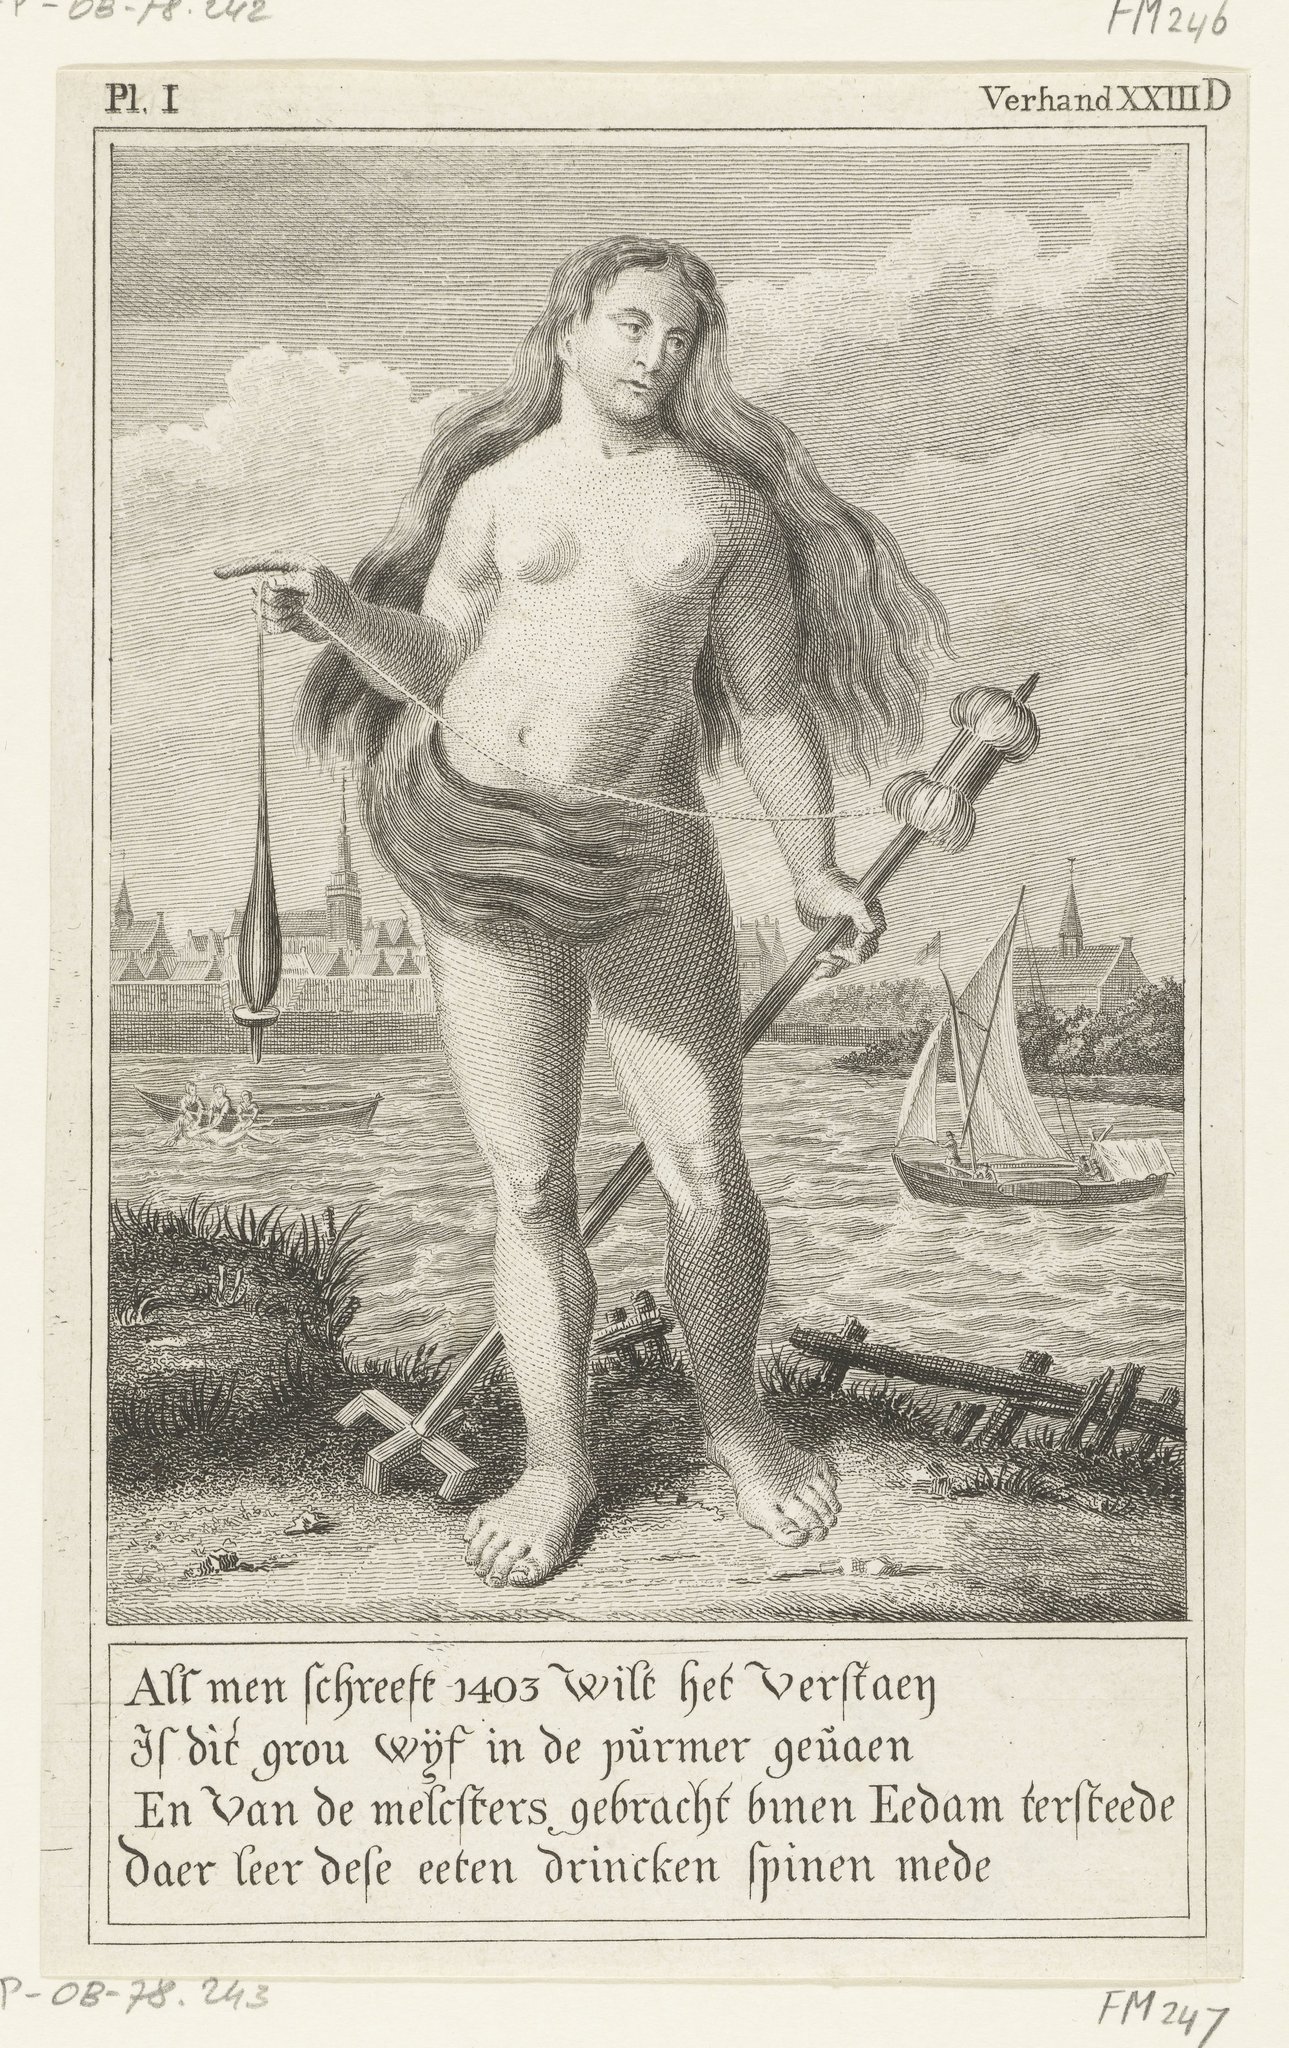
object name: print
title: Zeemeermin van Edam, 1403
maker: Anonymous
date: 1784-1786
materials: paper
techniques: engraving, etching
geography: northern netherlands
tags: merman, burgundian netherlands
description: De zeemeermin of Groene Wijf van Edam, 1403. Staande naakte vrouw met lang haar aan het spinnen. Op de achtergrond wordt de vrouw uit het water gevist en de stad Edam. Onder de voorstelling een vers van vier regels.